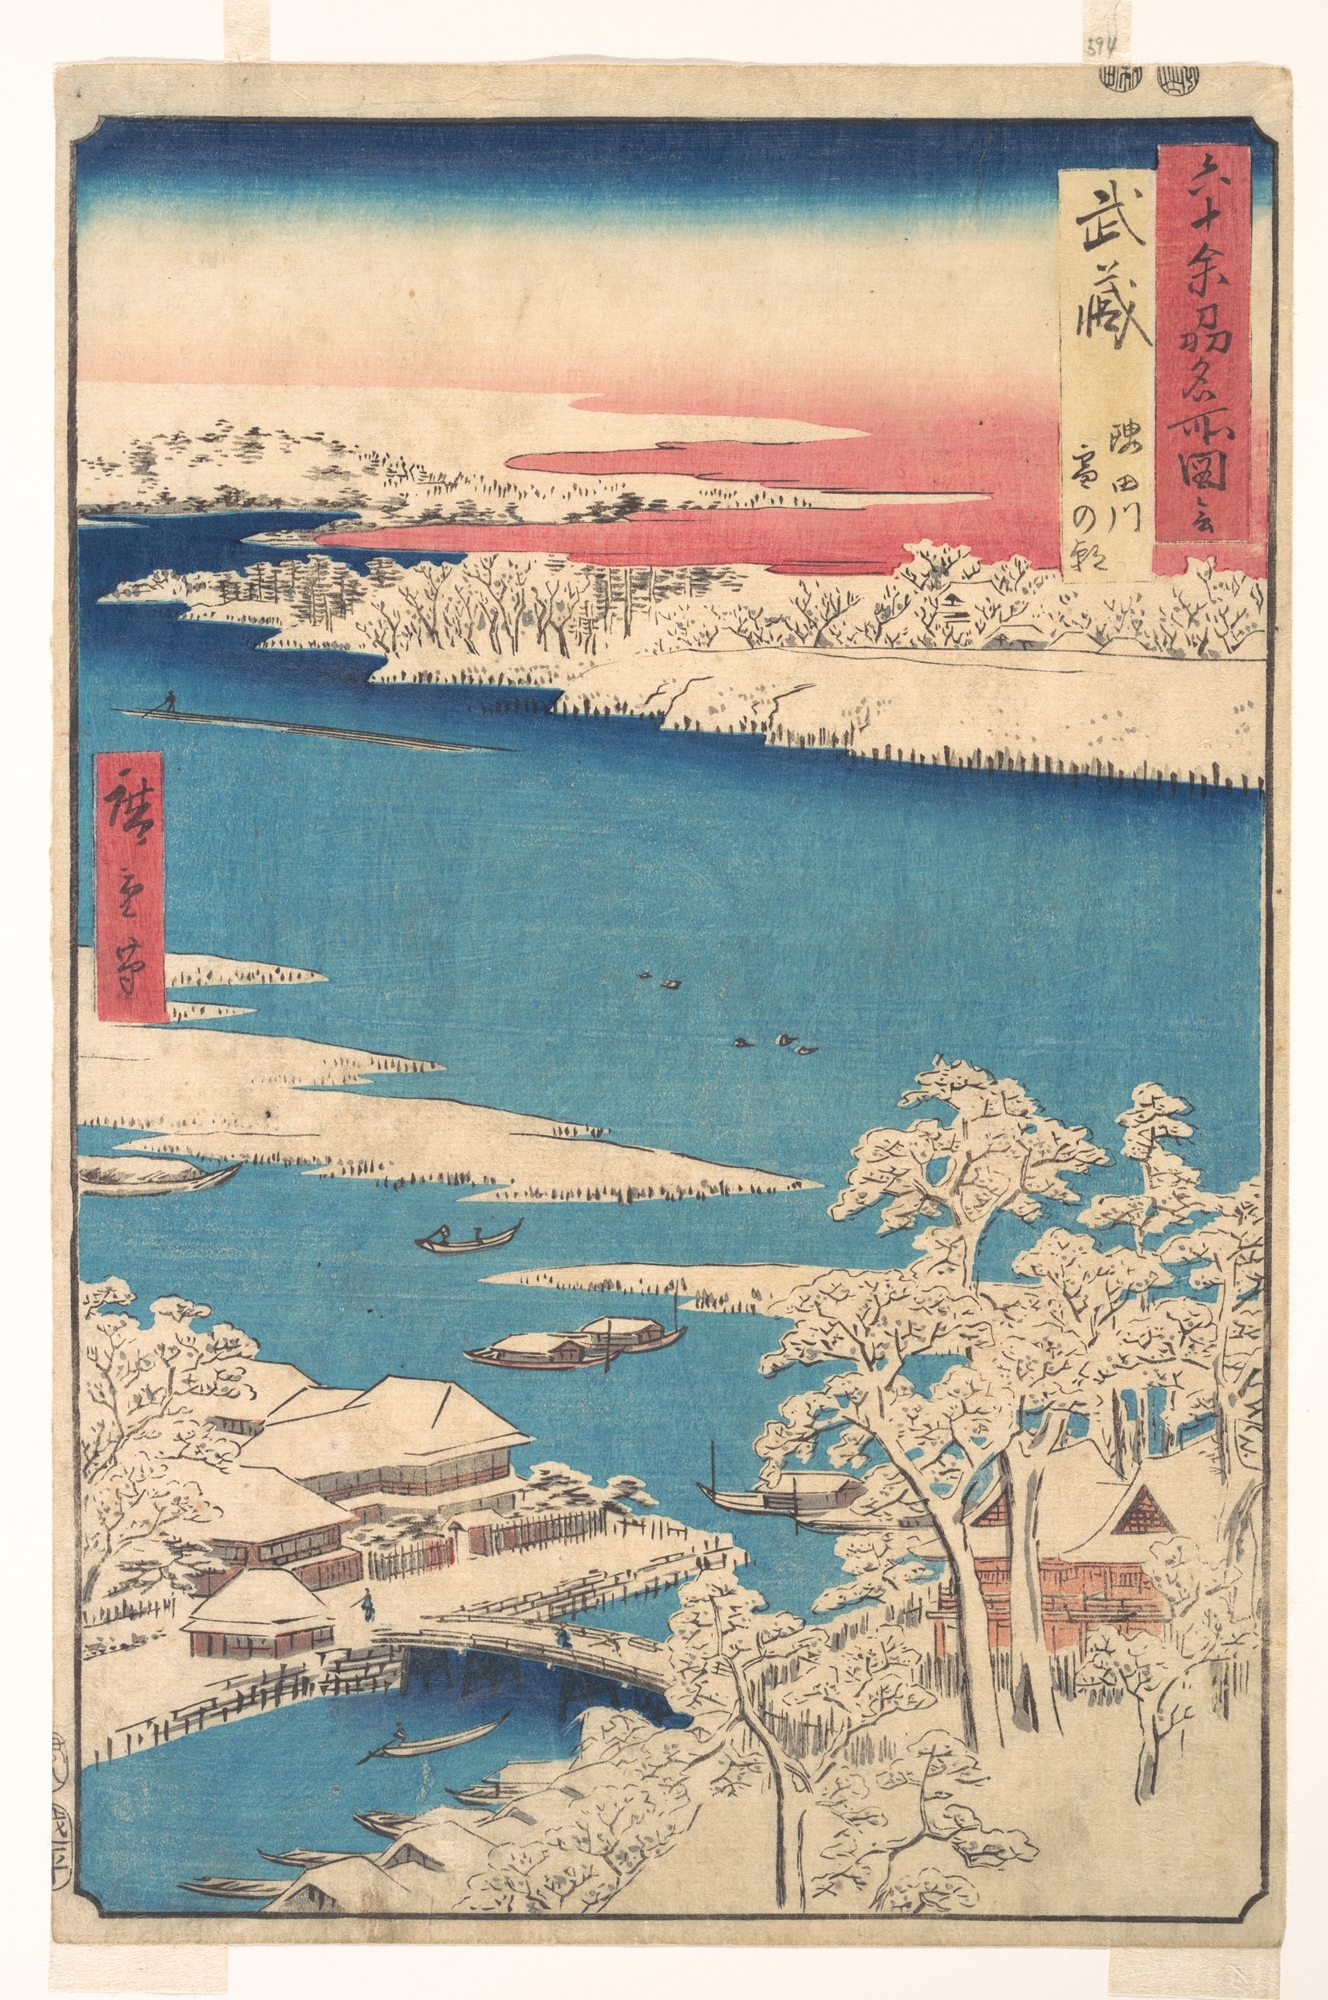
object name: print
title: Morning after a Snowfall, the Sumida River, Musashi Province , from the series Views of Famous Places in the Sixty-Odd Provinces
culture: japanese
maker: utagawa hiroshige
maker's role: artist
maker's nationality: japanese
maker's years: 1797-1858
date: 1853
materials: ink, paper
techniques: woodblock print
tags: rivers,trees,morning,snow